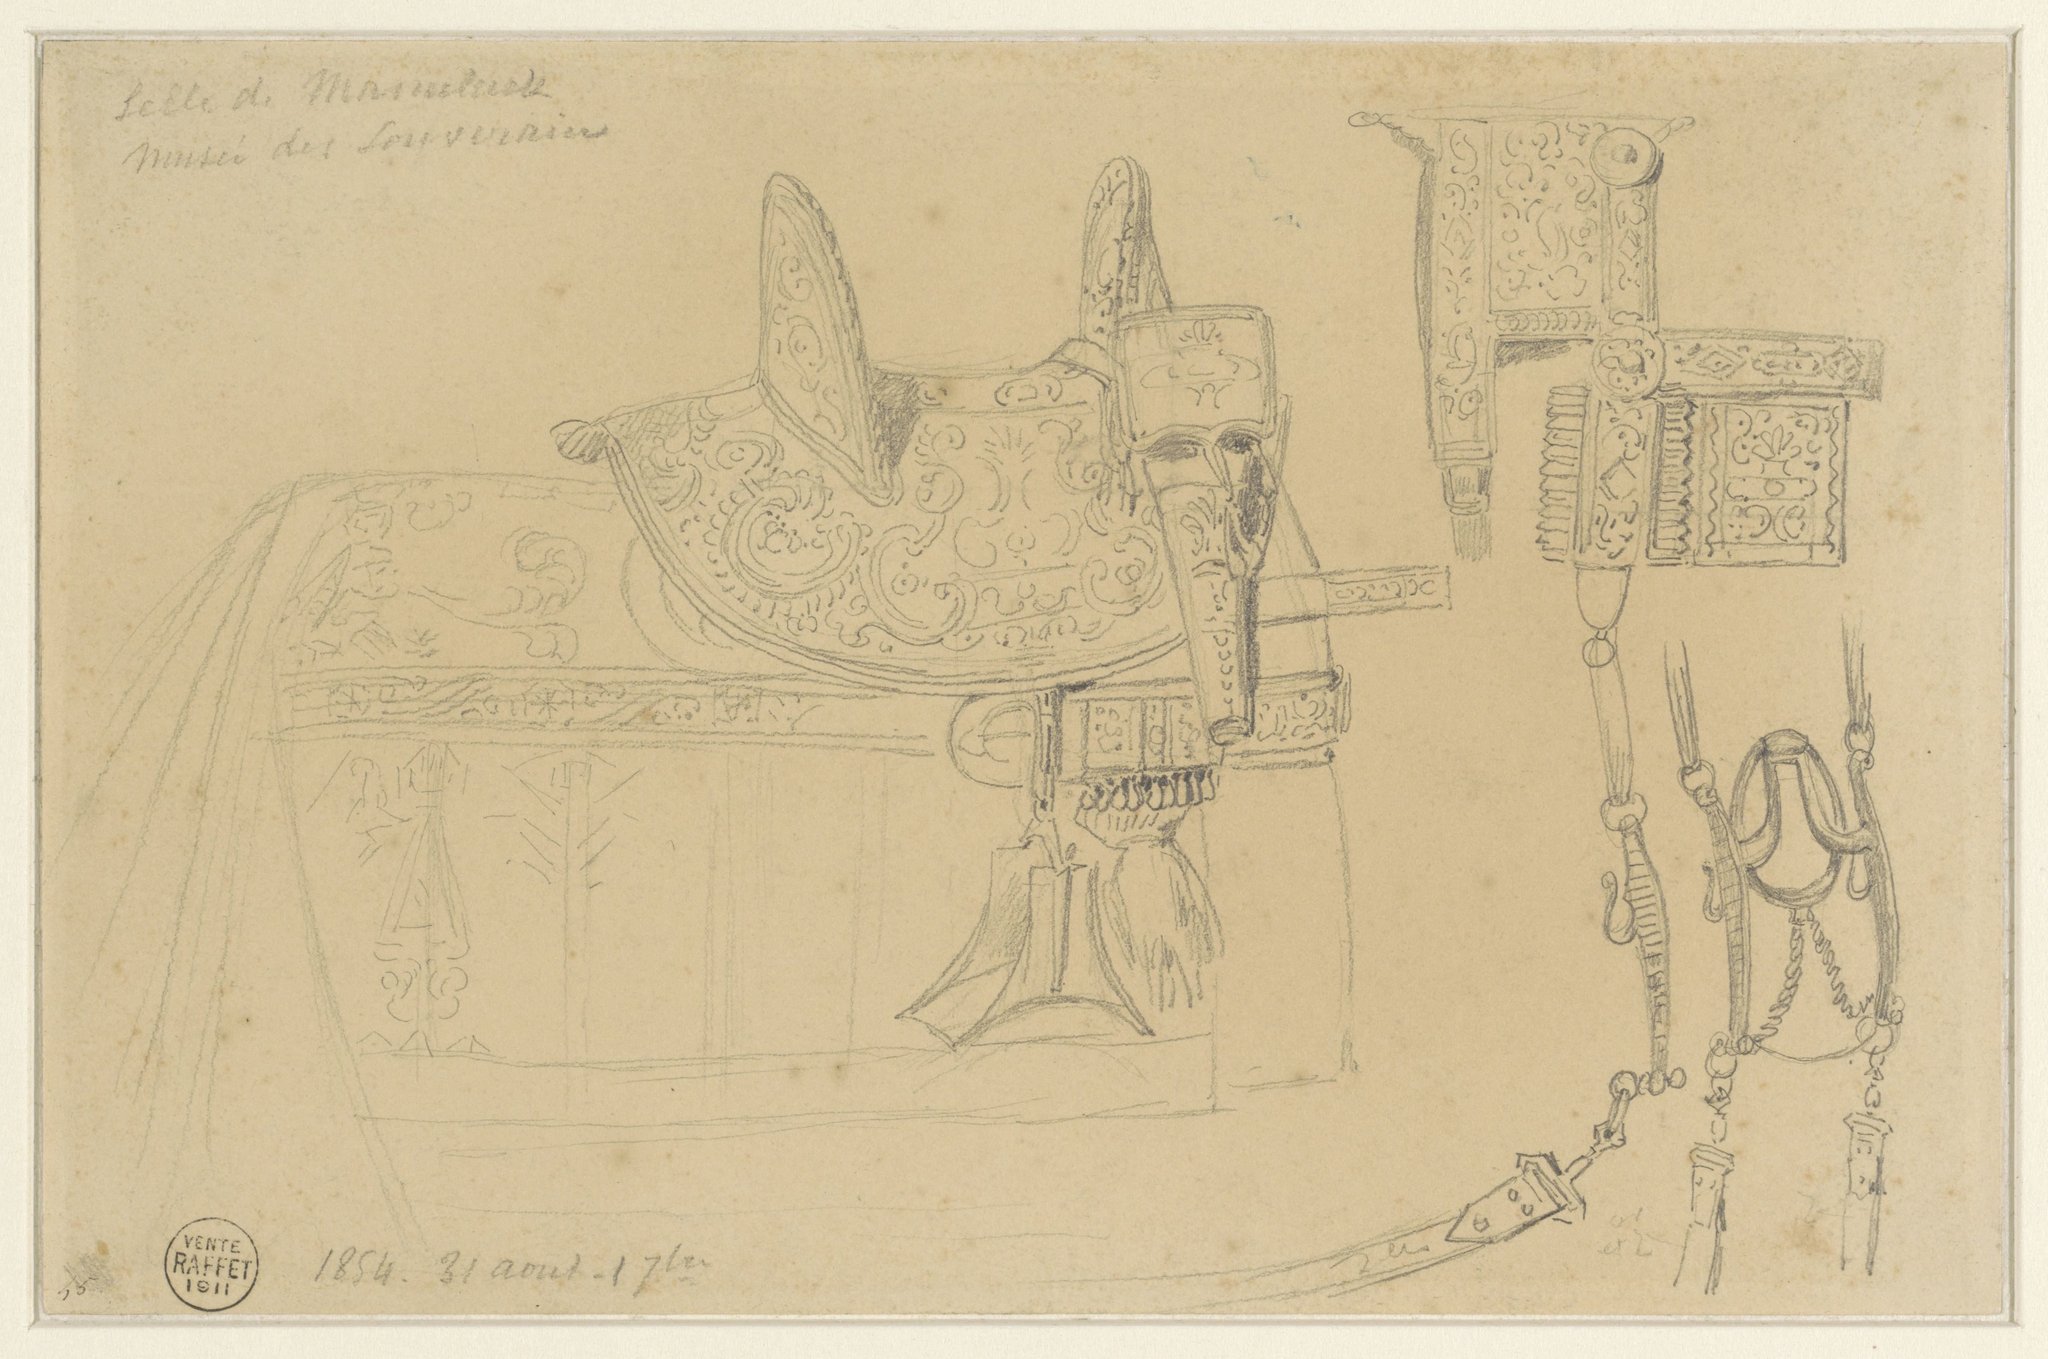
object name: drawing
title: Schetsblad met zadel van Mammeluk en onderdelen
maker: denis auguste marie raffet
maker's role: draughtsman, print maker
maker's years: 1804-1860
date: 1854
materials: paper, pencil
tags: asiatic races and peoples: turks, slavery; serfs and enslaved persons, saddle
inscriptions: annotation: ‘Selle de Mameluck, Musée des Souverains’